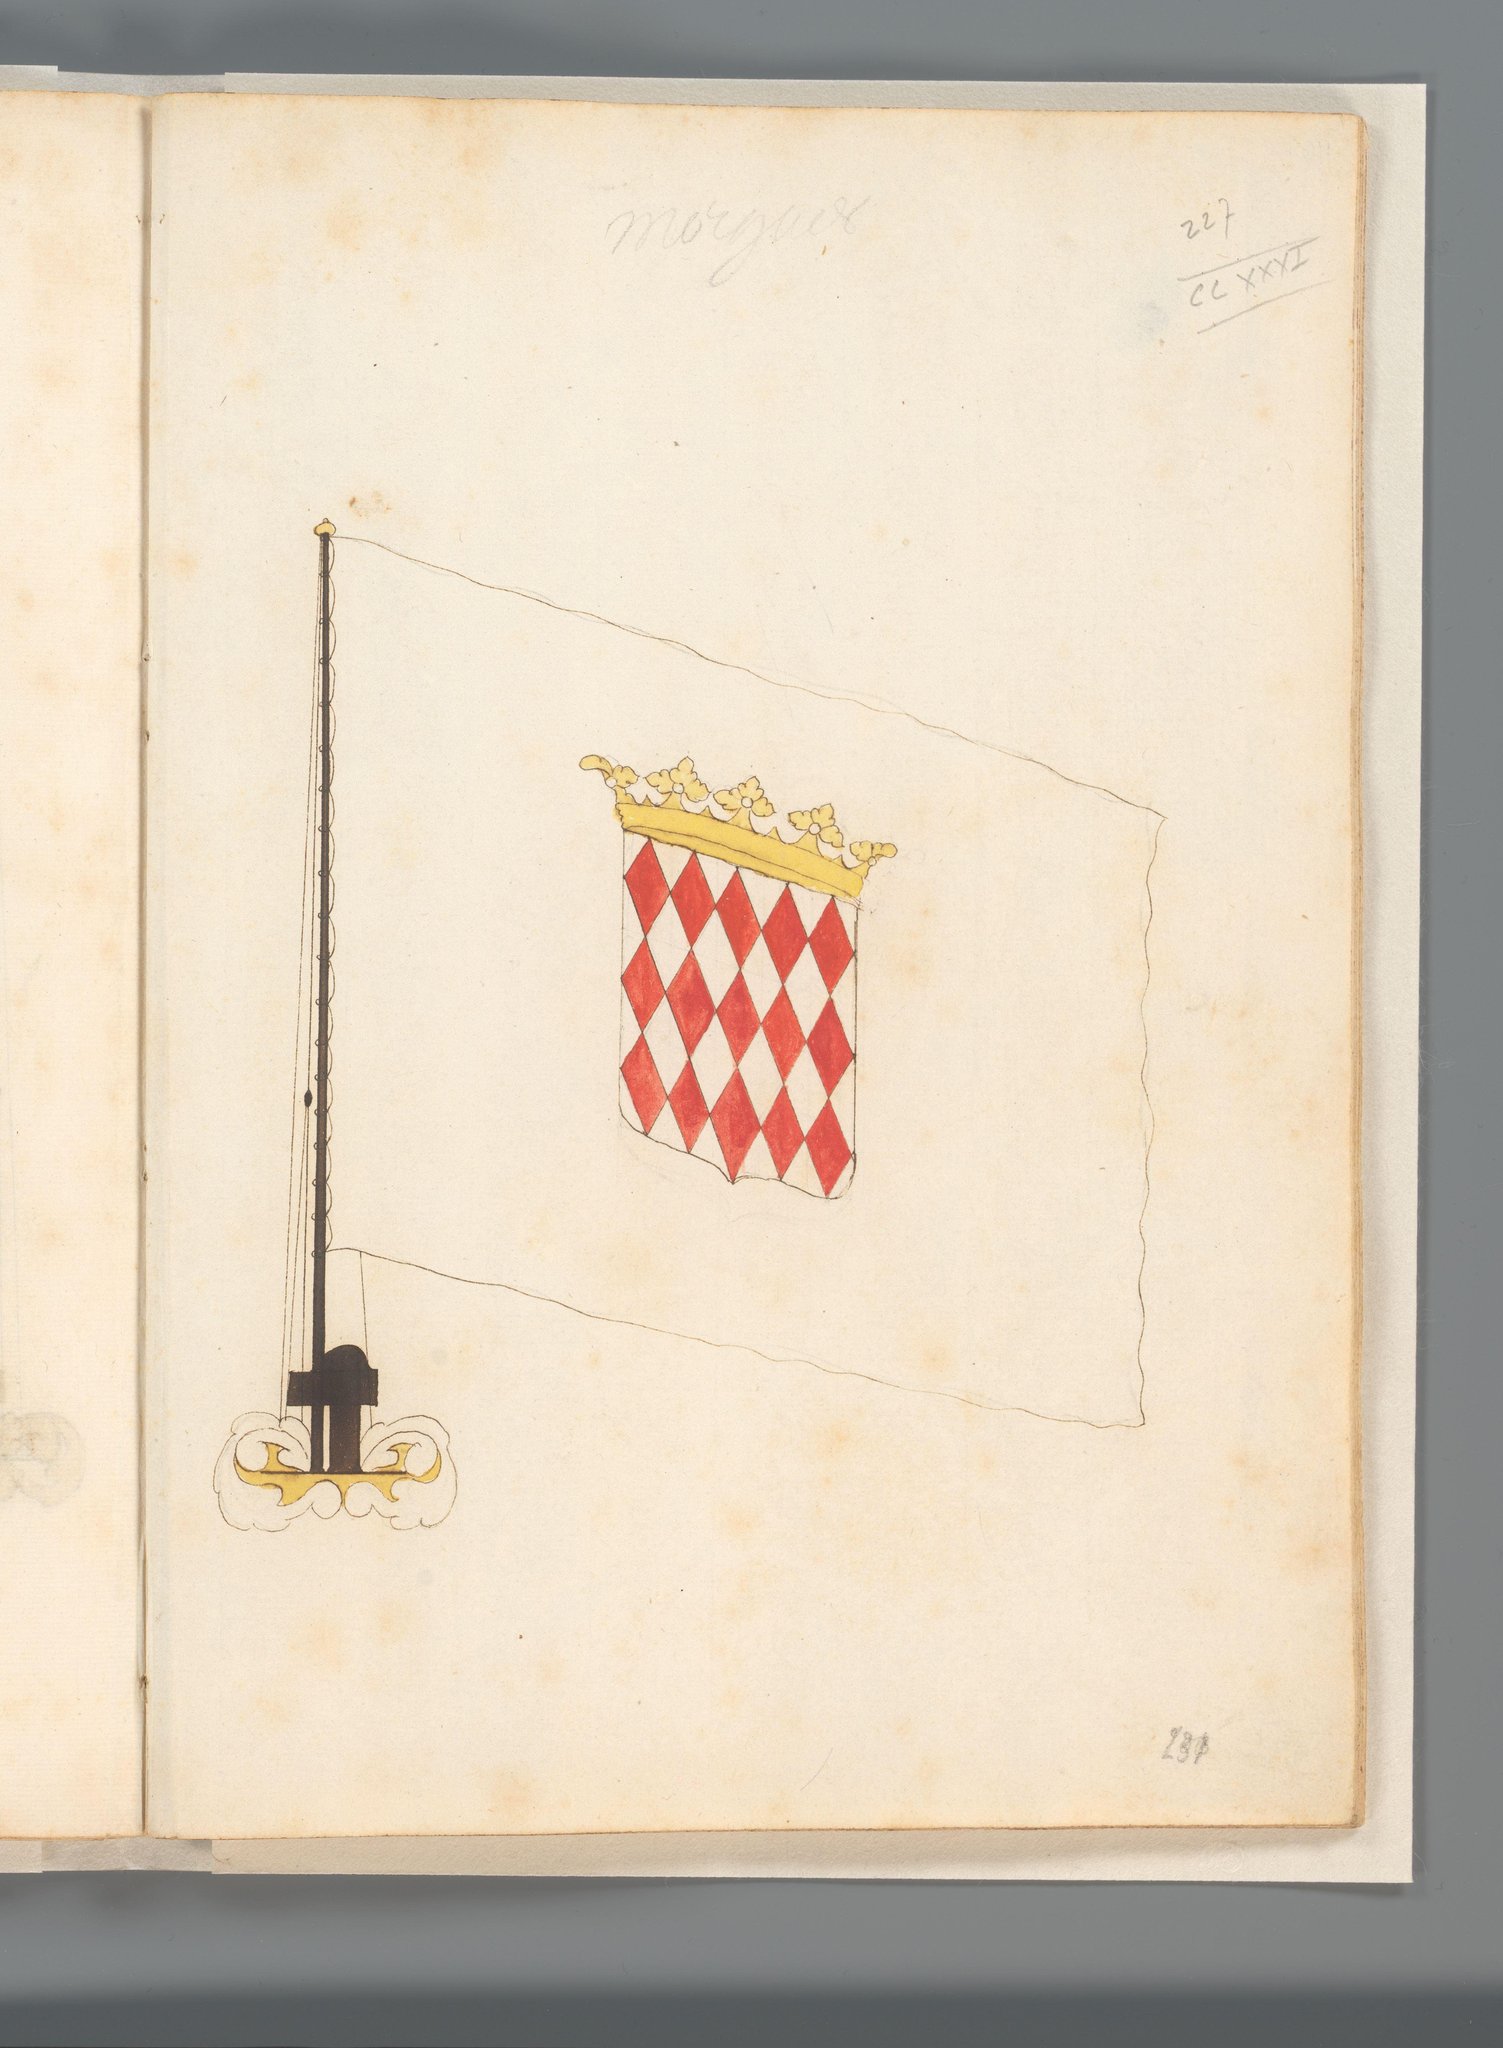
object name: drawing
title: Vlag van Monaco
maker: Anonymous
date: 1667-1670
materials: ink, paper, watercolor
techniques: brush, pen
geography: france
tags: flag, colours (as symbol of the state, etc.)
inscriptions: number: ‘227 / CCXXXI / 231’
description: Vlag van Monaco. Witte vlag waarop het rood en wit geschaakte wapen van de stad Monaco (en het Huis Grimaldi) onder een kroon. Vlag op vlaggensteng en mastvoet. Afgebeeld op folio 116r. Onderdeel van een vlaggenboek met vlaggen uit Europa, Noord-Afrika, Nabije en Verre Oosten.